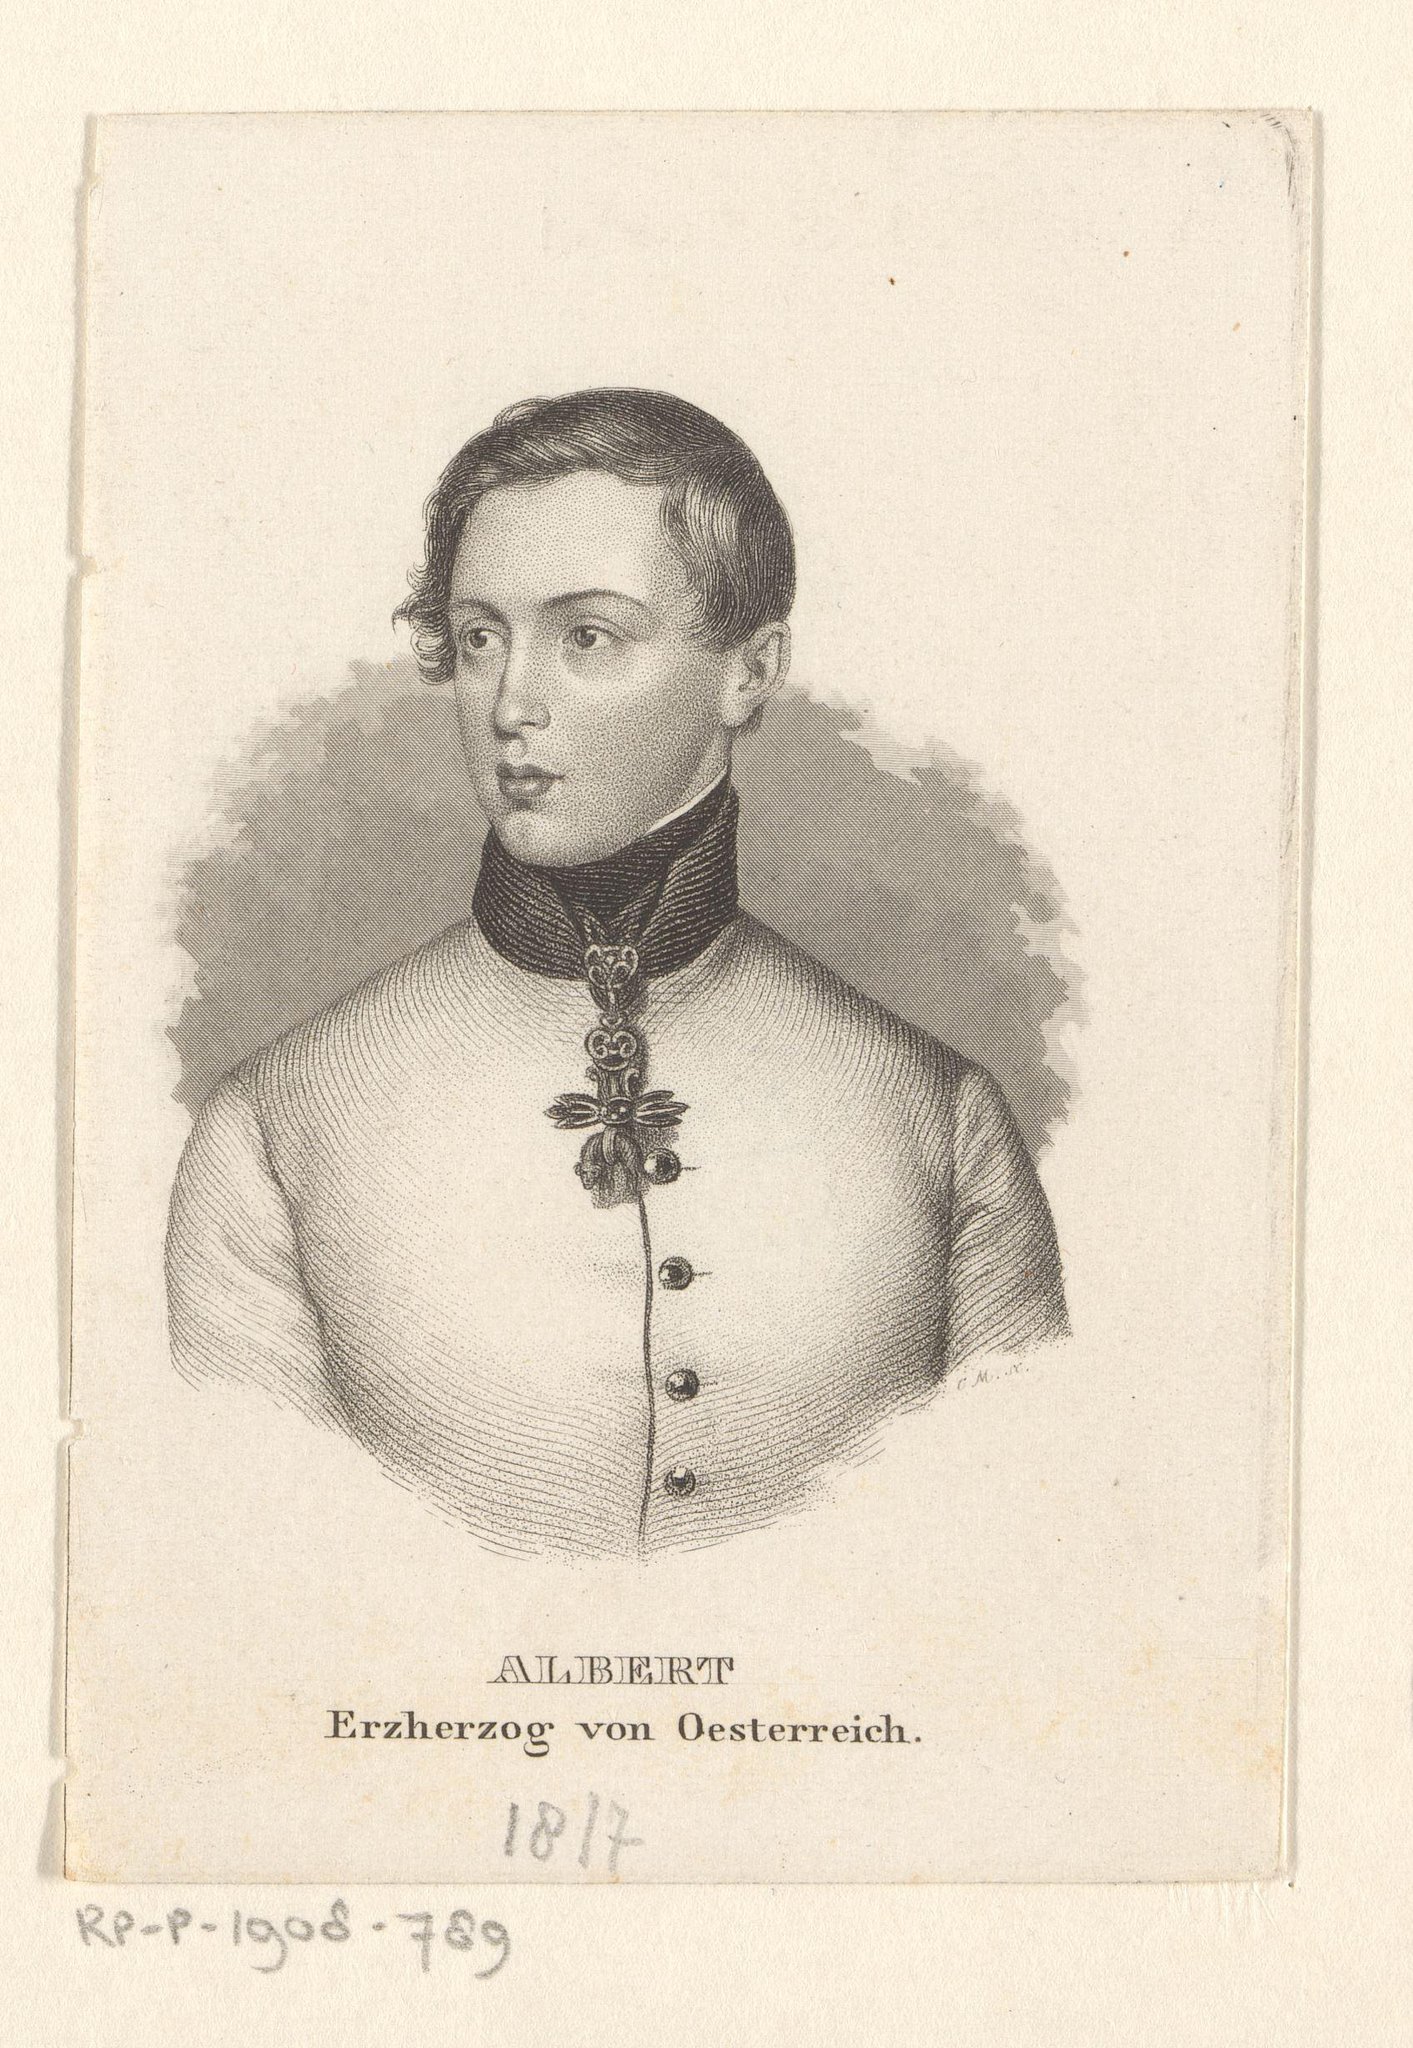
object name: print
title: Portret van Albrecht von Österreich-Teschen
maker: carl mayer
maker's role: print maker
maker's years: 1798-1868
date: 1817-1868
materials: paper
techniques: engraving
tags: vienna, historical persons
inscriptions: collector's mark: Lugt 2228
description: Prent mogelijk afkomstig uit de Almanach de Gotha.